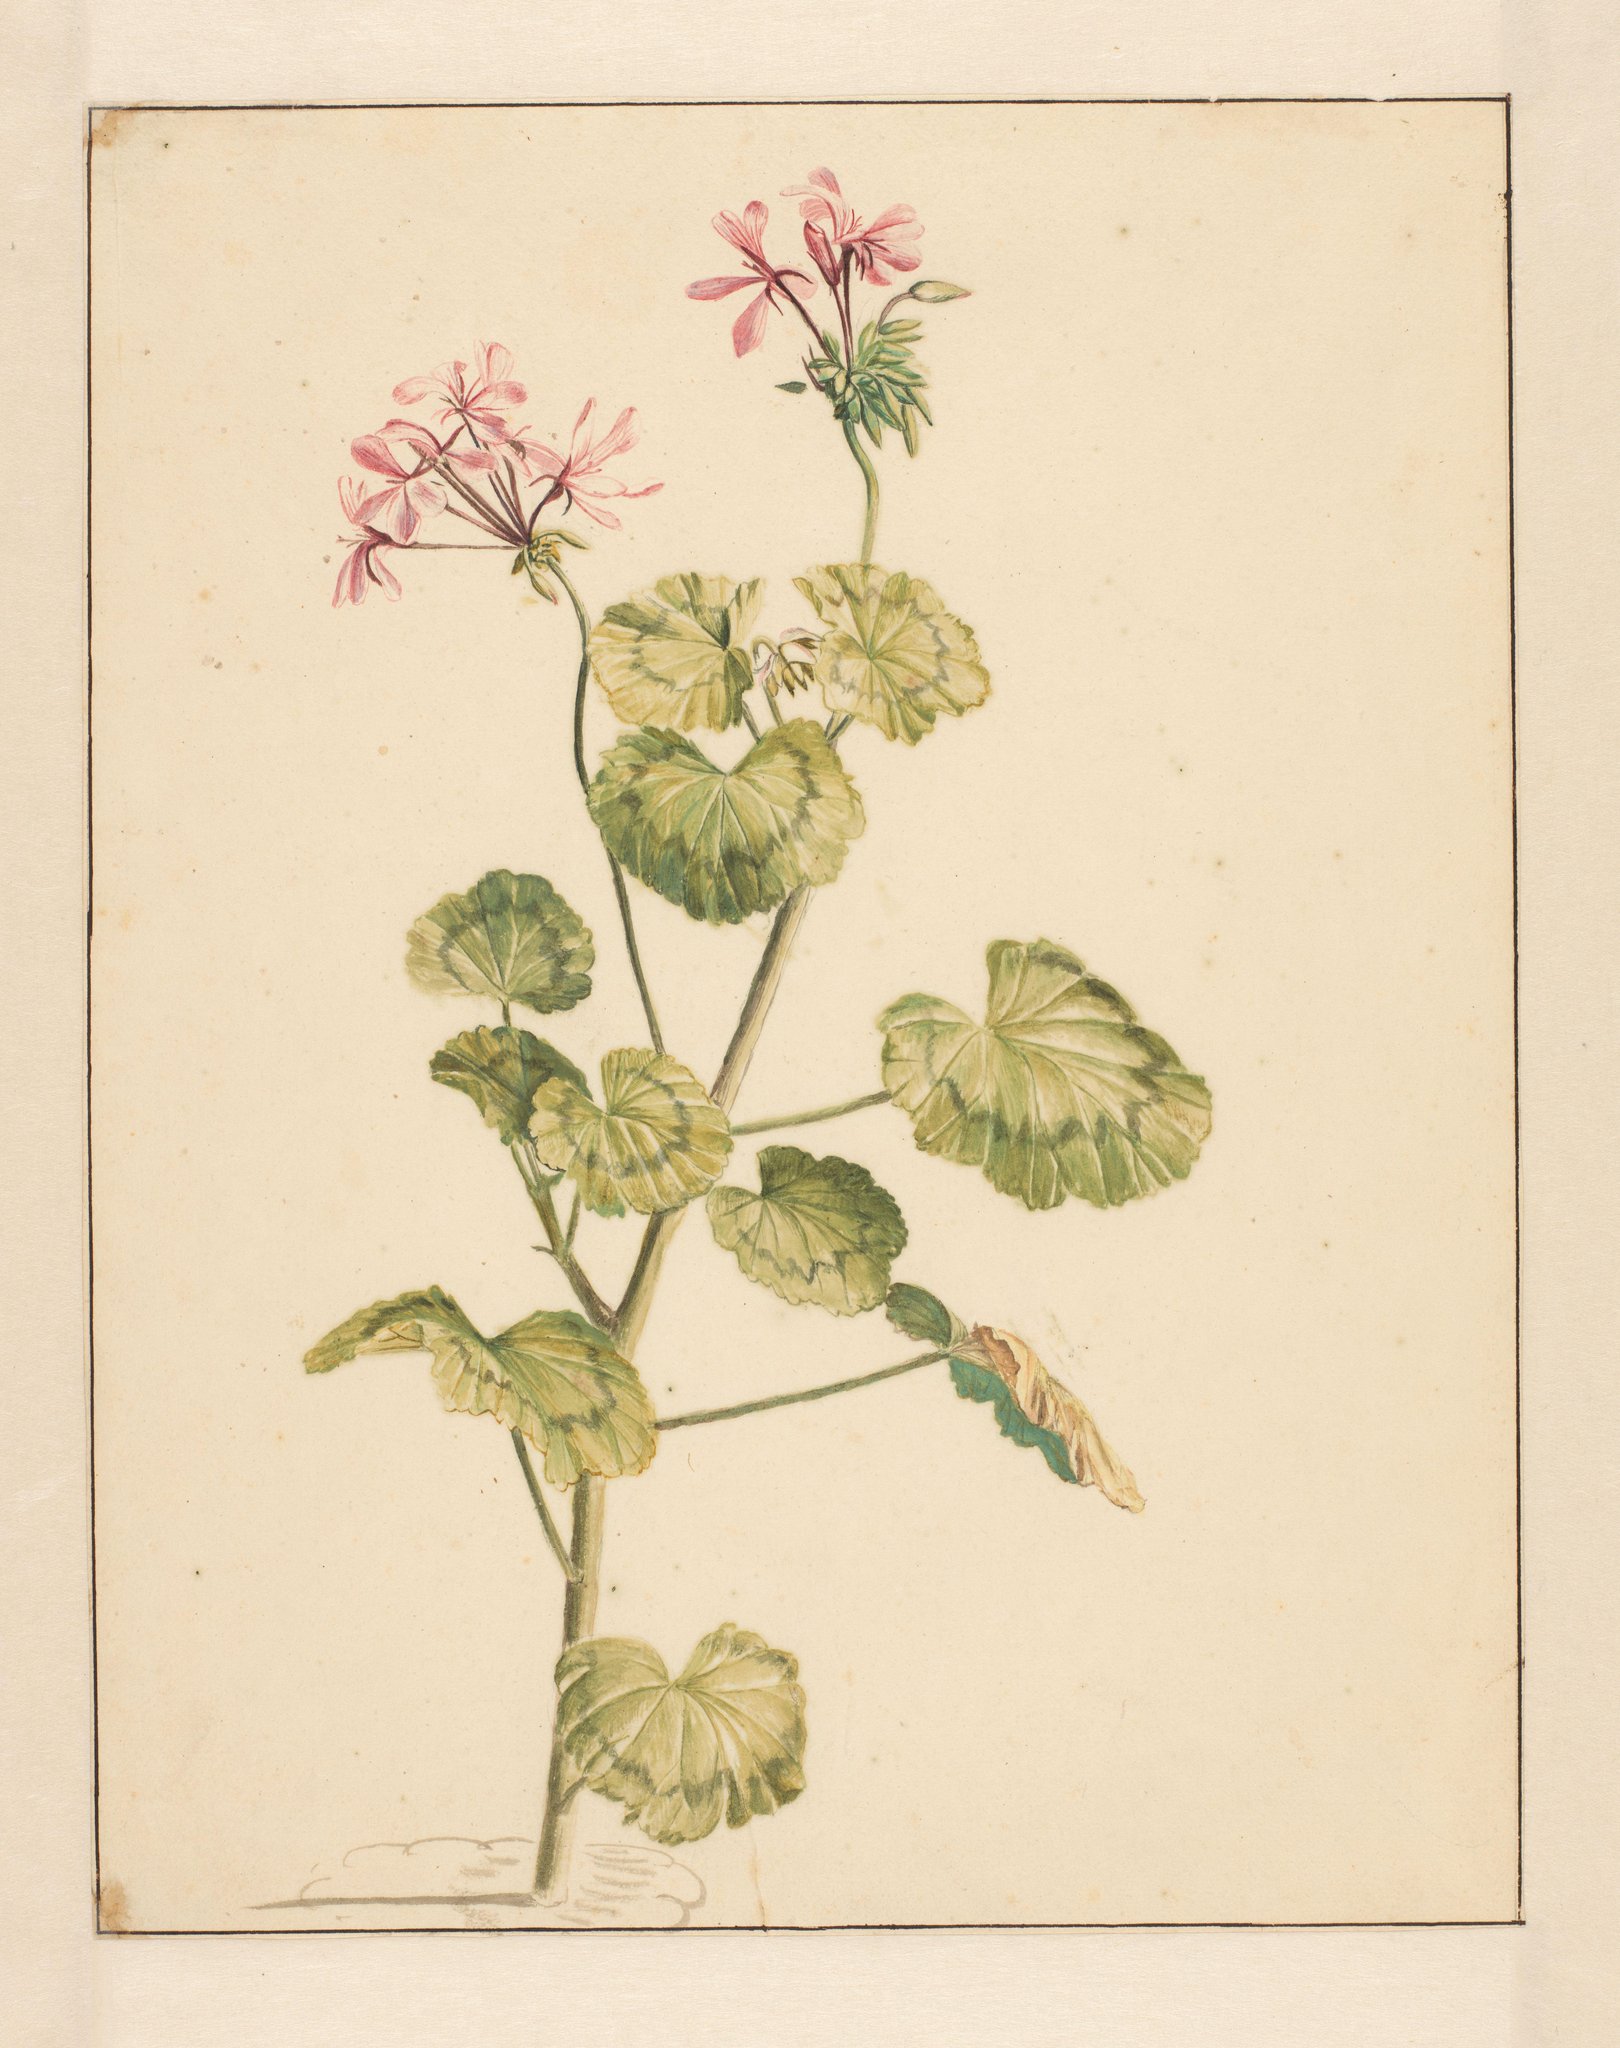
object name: drawing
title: Geranium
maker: laurens vincentsz. van der vinne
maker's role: draughtsman, print maker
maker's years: 1658-1729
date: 1668-1729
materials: paper, pencil, watercolor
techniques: brush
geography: netherlands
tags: flowers: geranium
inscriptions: inscription: ‘Pelargonium’